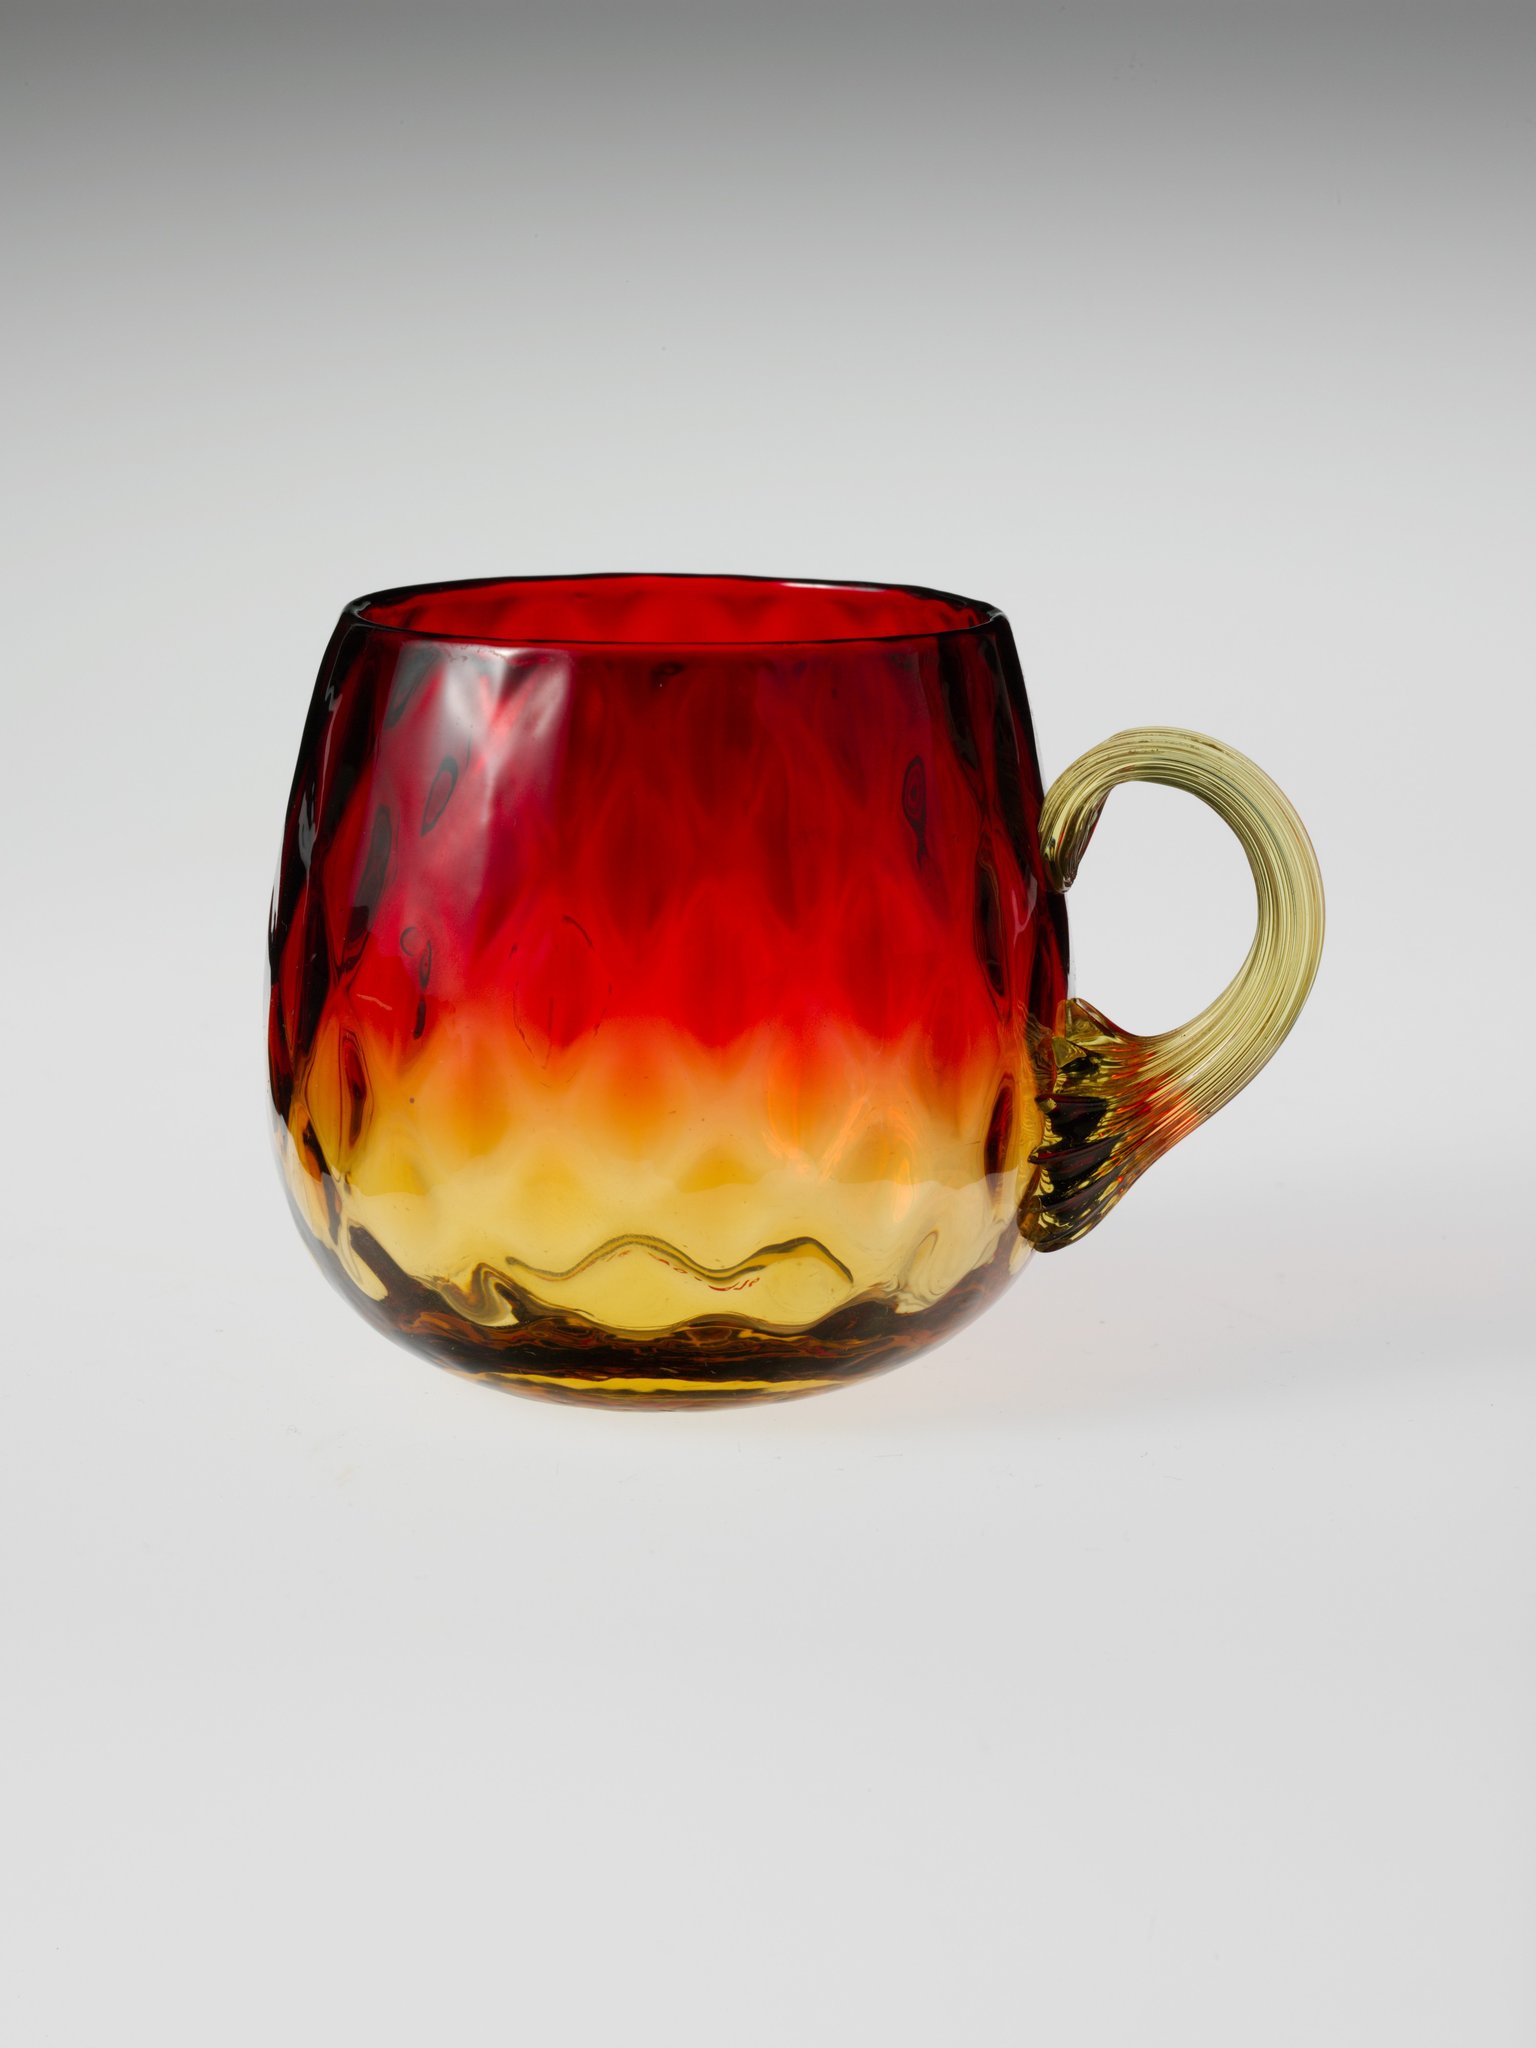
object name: cup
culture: american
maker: new england glass company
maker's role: maker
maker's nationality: american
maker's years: 1818-1888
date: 1801-1900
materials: glass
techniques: glassblowing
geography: united states